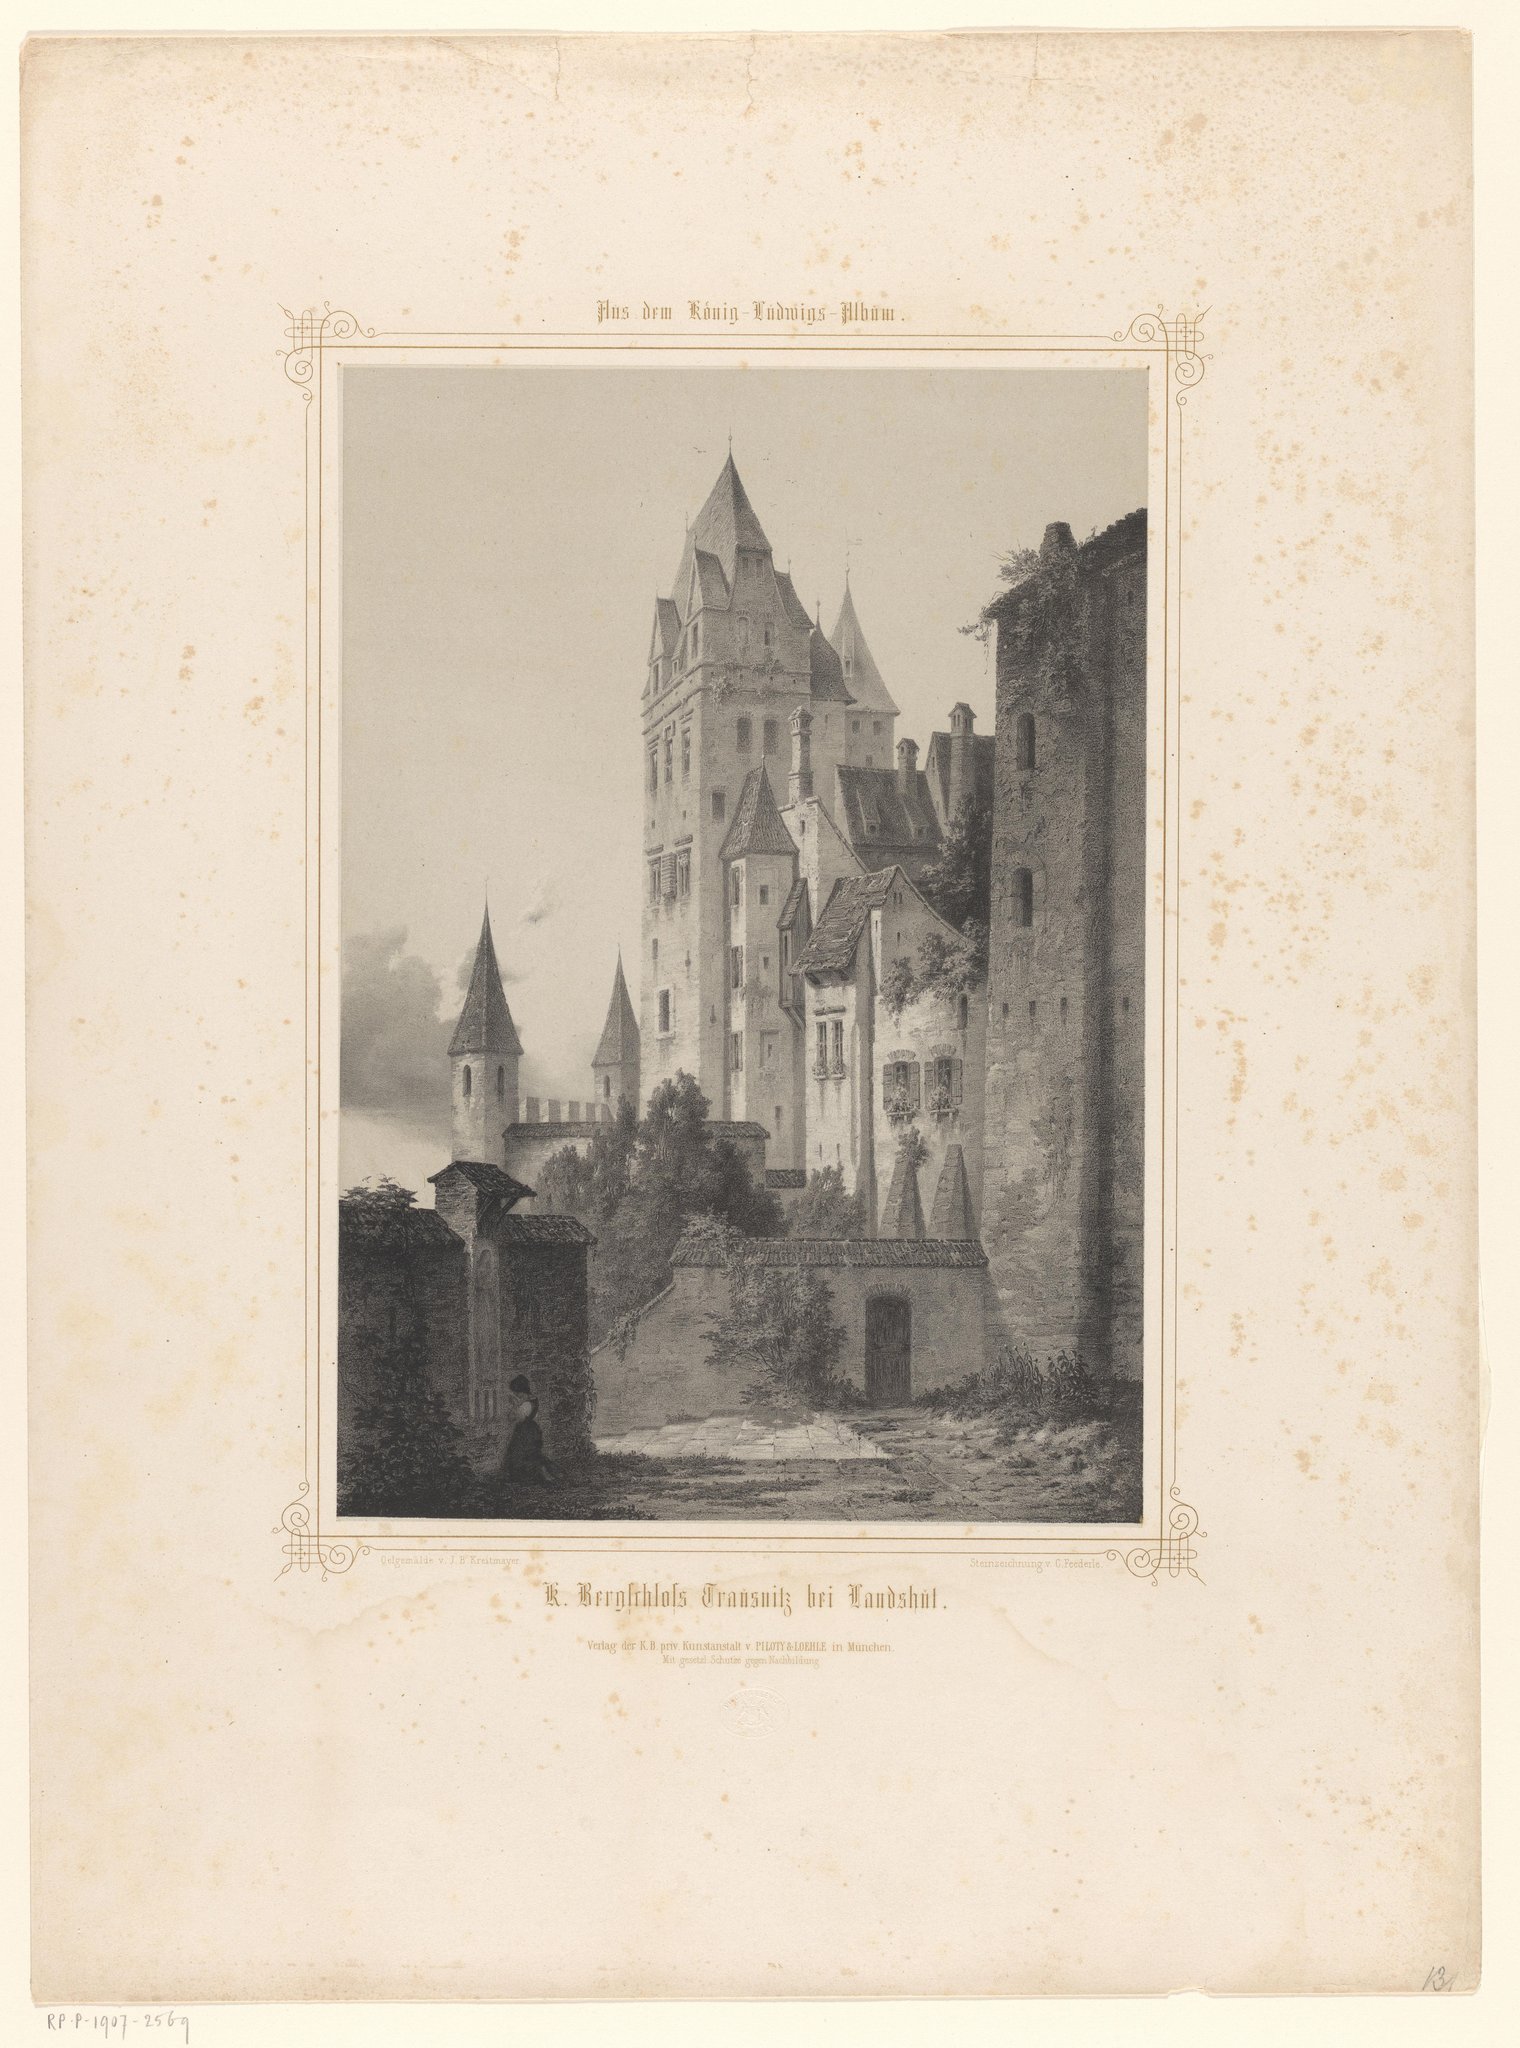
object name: print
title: K. Bergschloss Trausnitz bei Landshut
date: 1850-1859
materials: paper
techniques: tone lithography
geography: munich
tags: castle, one person praying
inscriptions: check stamp: ‘Piloty&Loehle, München’, collector's mark: Lugt 2228, : ‘Mit gesetzl Schutze gegen Nachbildung’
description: Prent afkomstig uit de serie 'Album Seiner Majestät des Königs Ludwig I. von Bayern', verschenen in verschillende afleveringen. De prenten gaan terug op het album dat Lodewijk I van Beieren op 9 oktober 1850 kreeg overhandigd van verschillende kunstenaars.